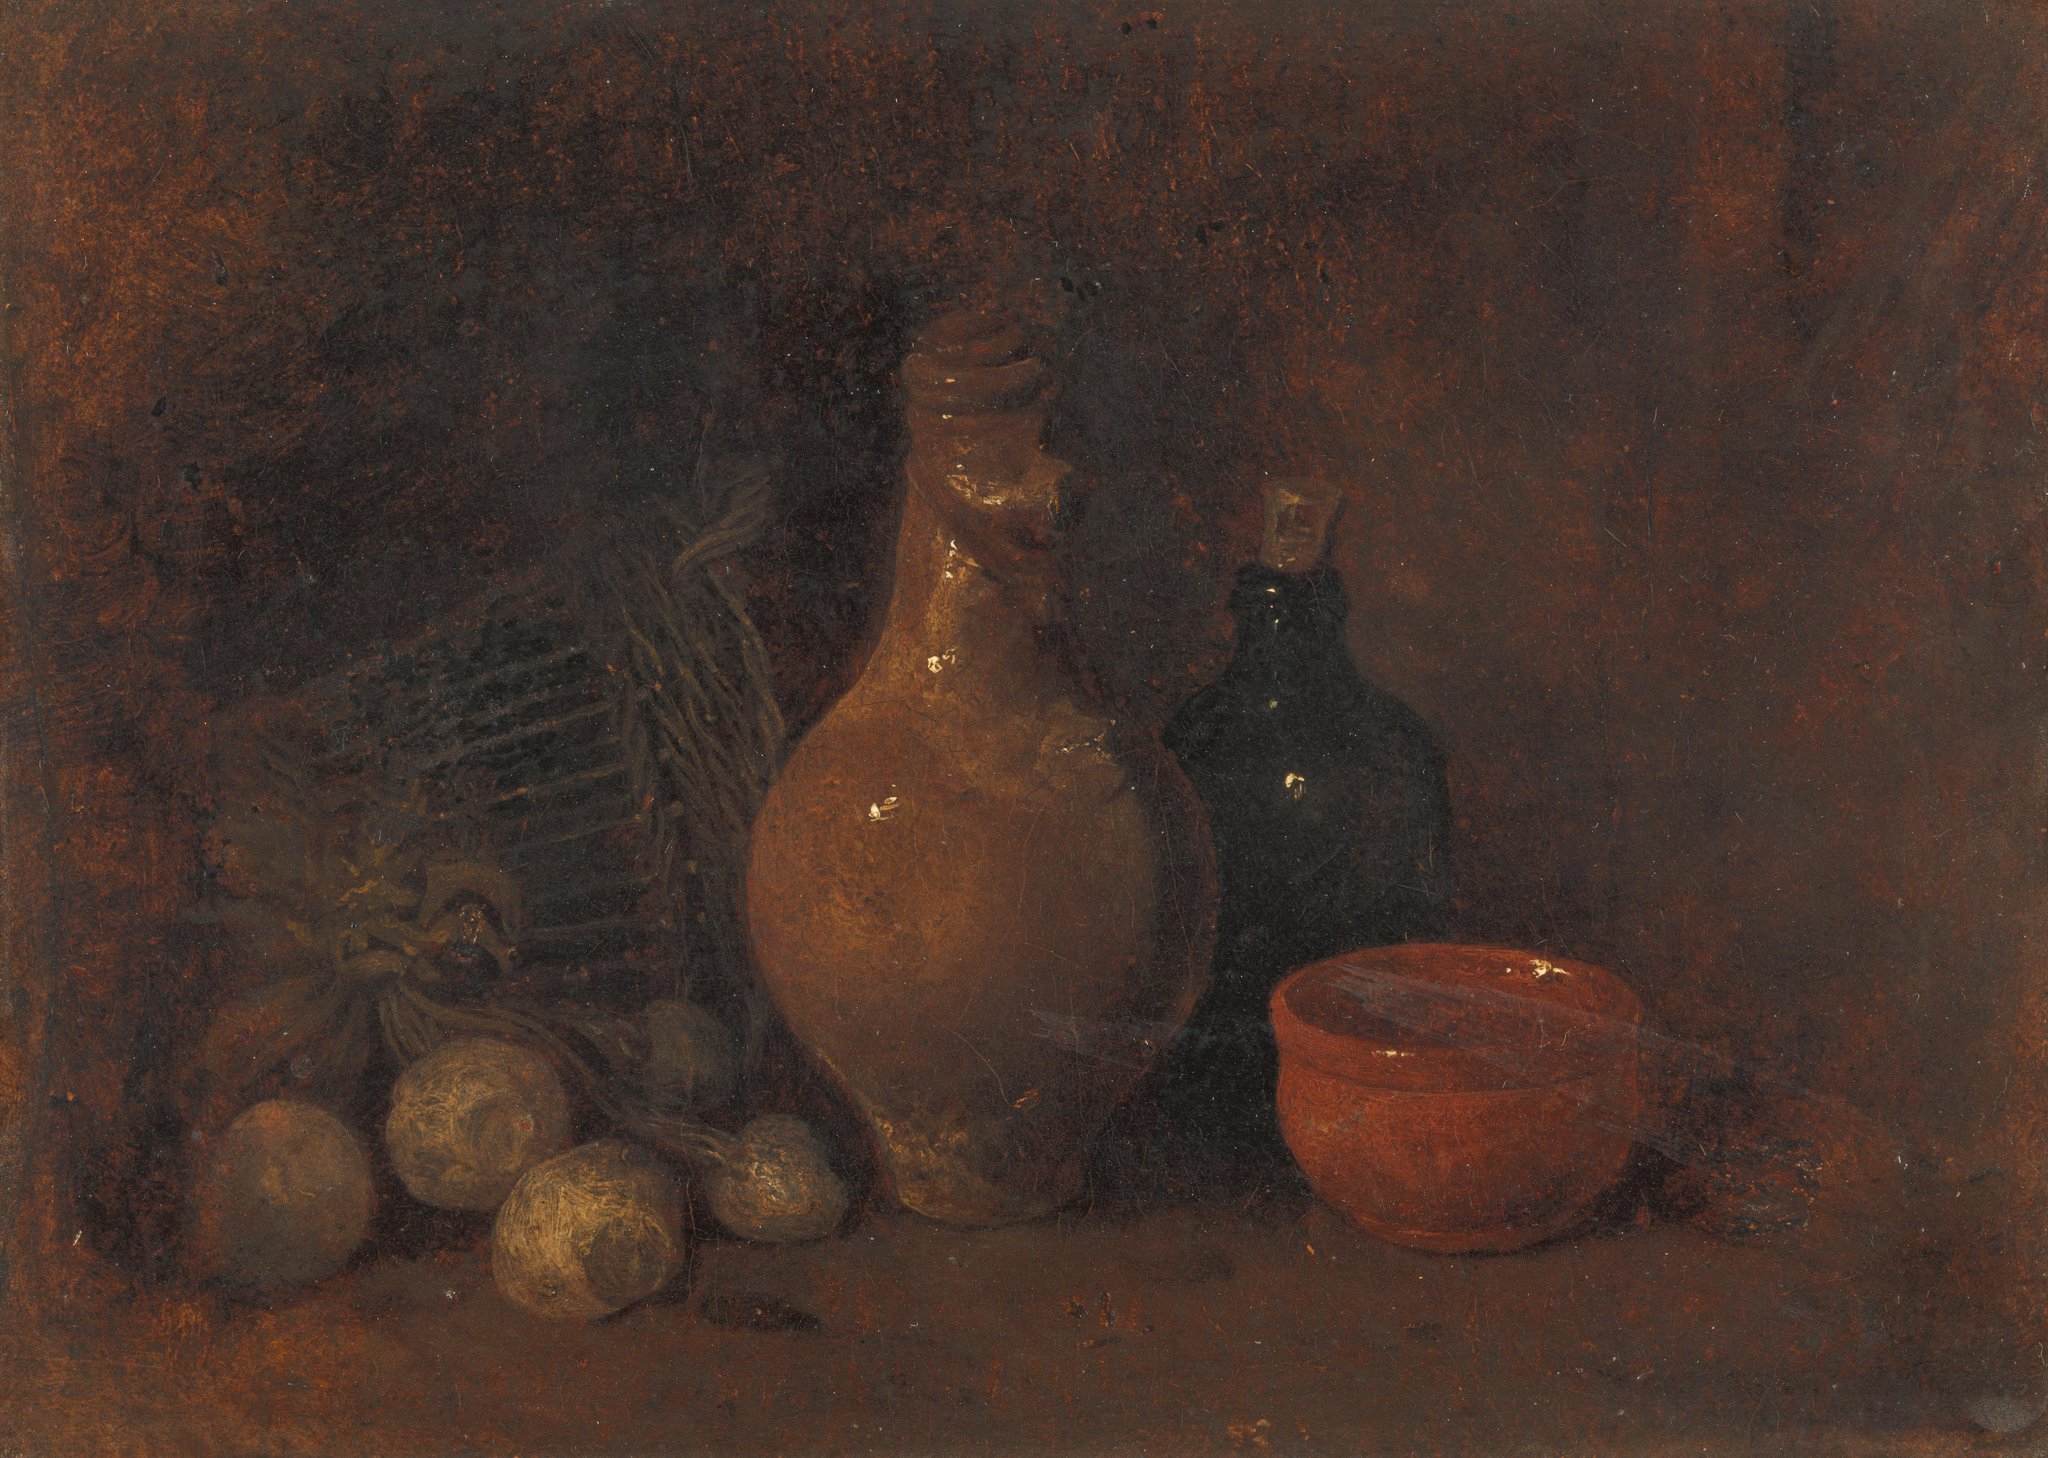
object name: painting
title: Stilleven met vier vruchten, glas en aardewerk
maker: françois bonvin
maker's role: draughtsman, print maker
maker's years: 1817-1887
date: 1827-1887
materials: oil, panel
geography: france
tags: still life of miscellaneous objects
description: Stilleven met vier vruchten, glas en aardewerk.